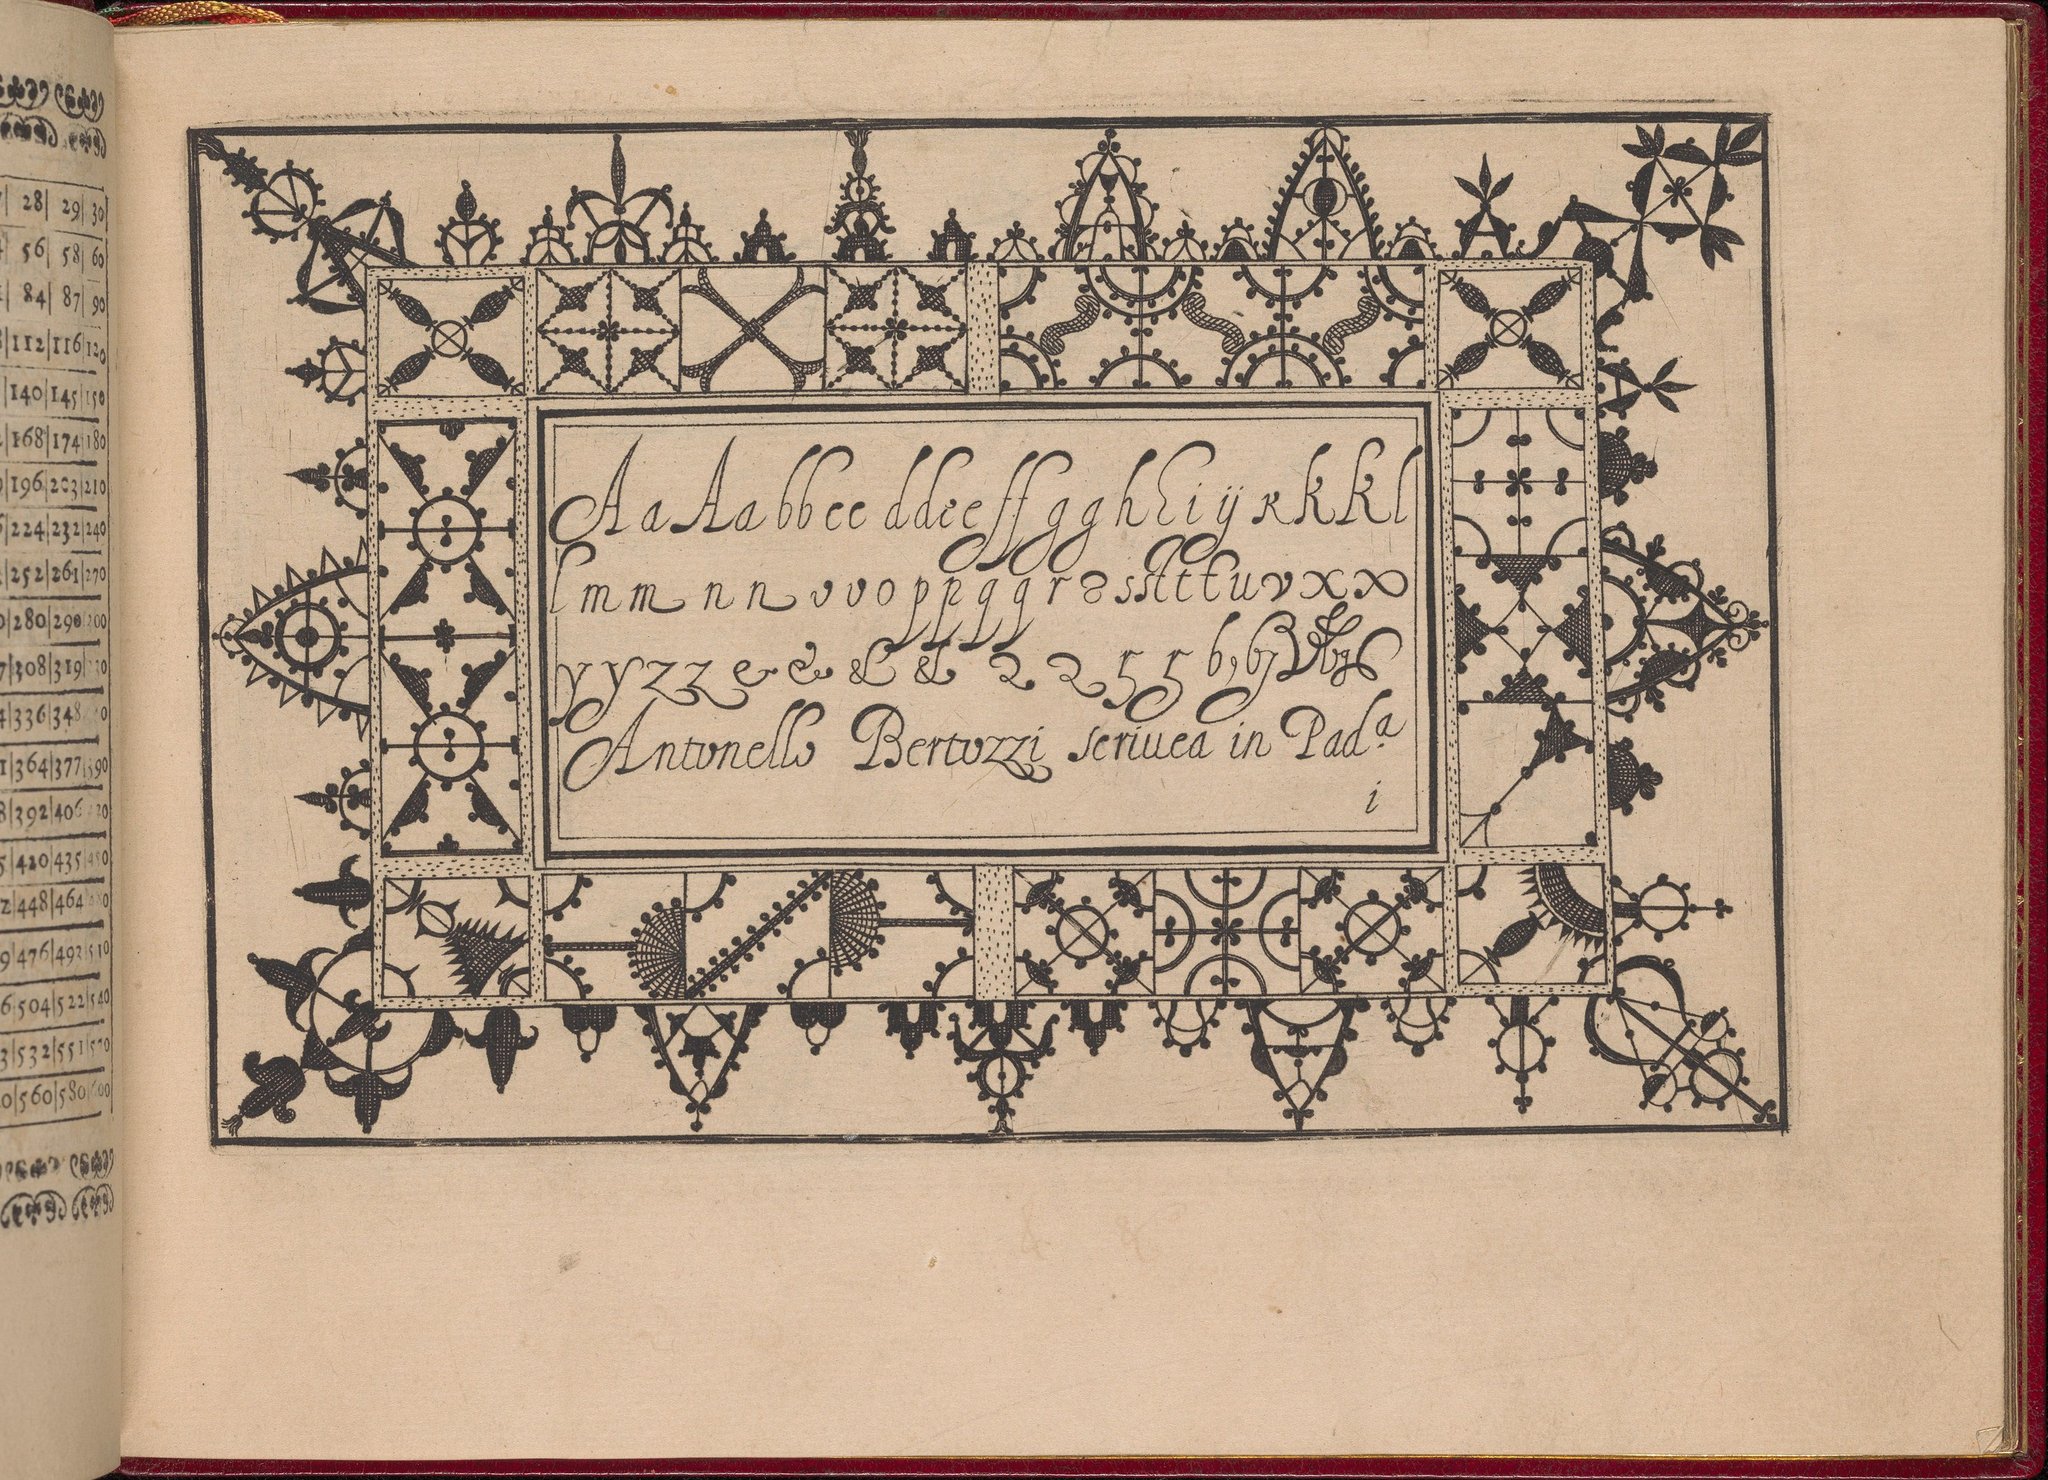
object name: book print ornament architecture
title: Ghirlanda: Di sei vaghi fiori scielti da piu famosi Giardini d'Italia, page 9 (recto)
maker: pietro paulo tozzi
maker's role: designer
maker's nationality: italian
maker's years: 1593-1628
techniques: drawing, etching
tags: ornament